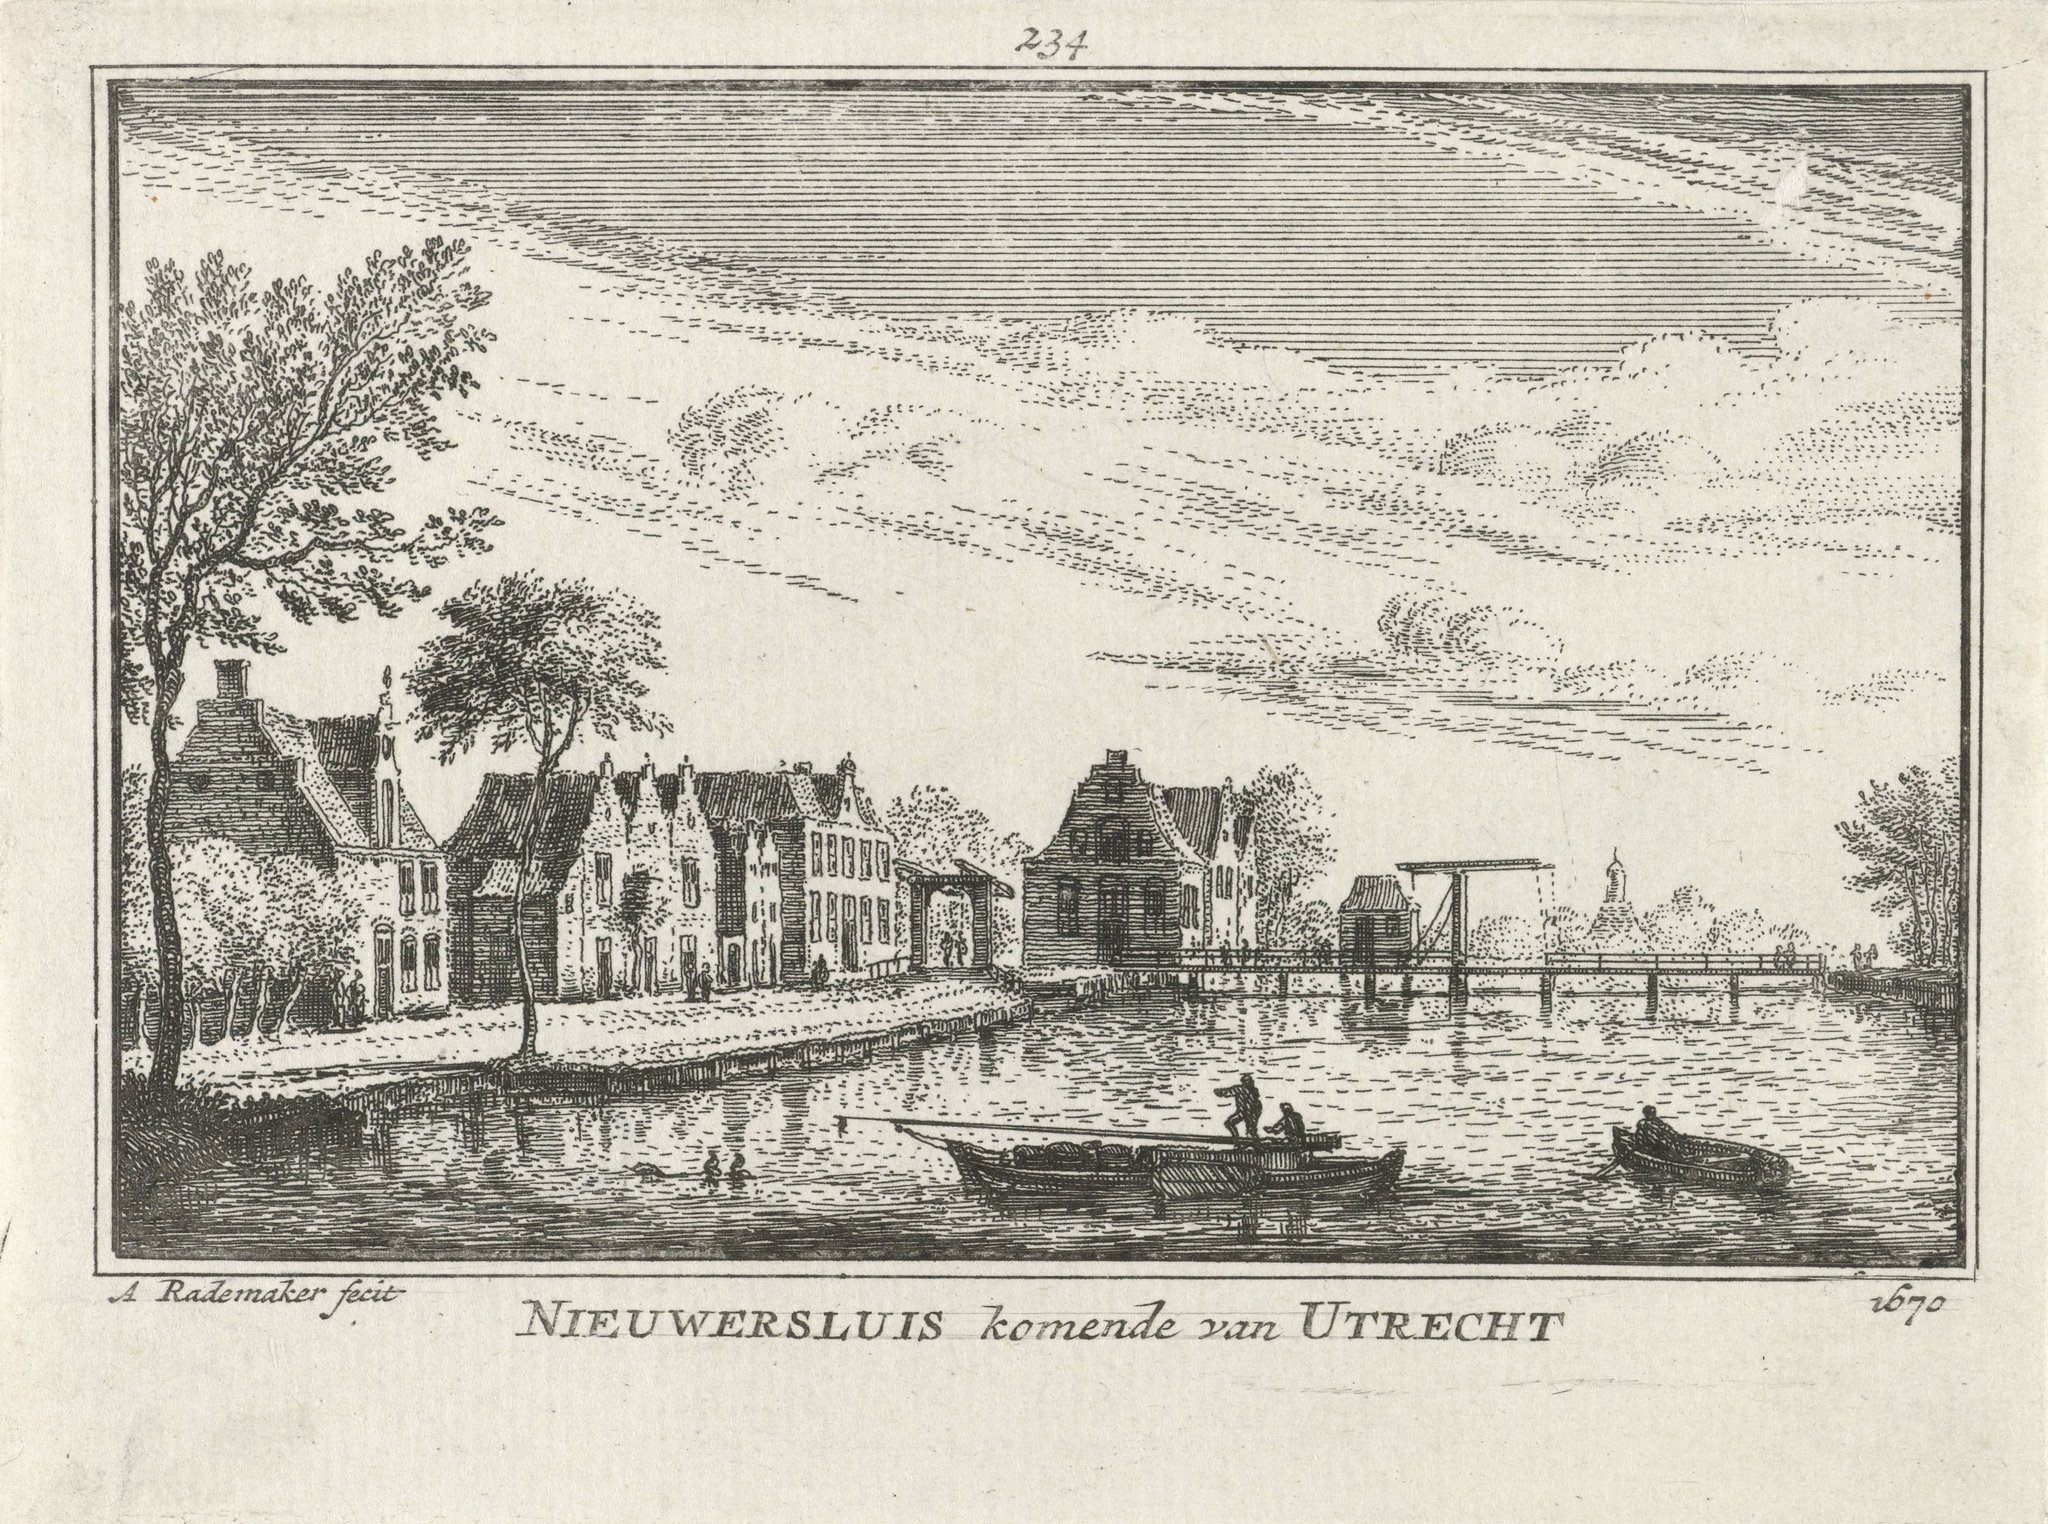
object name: book illustration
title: Nieuwersluis komende van Utrecht 1670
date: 1727-1733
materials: paper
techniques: etching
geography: amsterdam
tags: prospect of village, silhouette of village, rowing-boat, canoe, etc., bridge, vecht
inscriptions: collector's mark: Lugt 2228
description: Illustratie uit: Abraham Rademaker, Matthaeus Brouërius van Niedek, Isaac Le Long, Kabinet van Nederlandsche en Kleefsche outheden en (...) voorname stads- en landgebouwen, Willem Barents en Antoni Schoonenburg: Amsterdam, 1727-1733, ill. nr. 234.